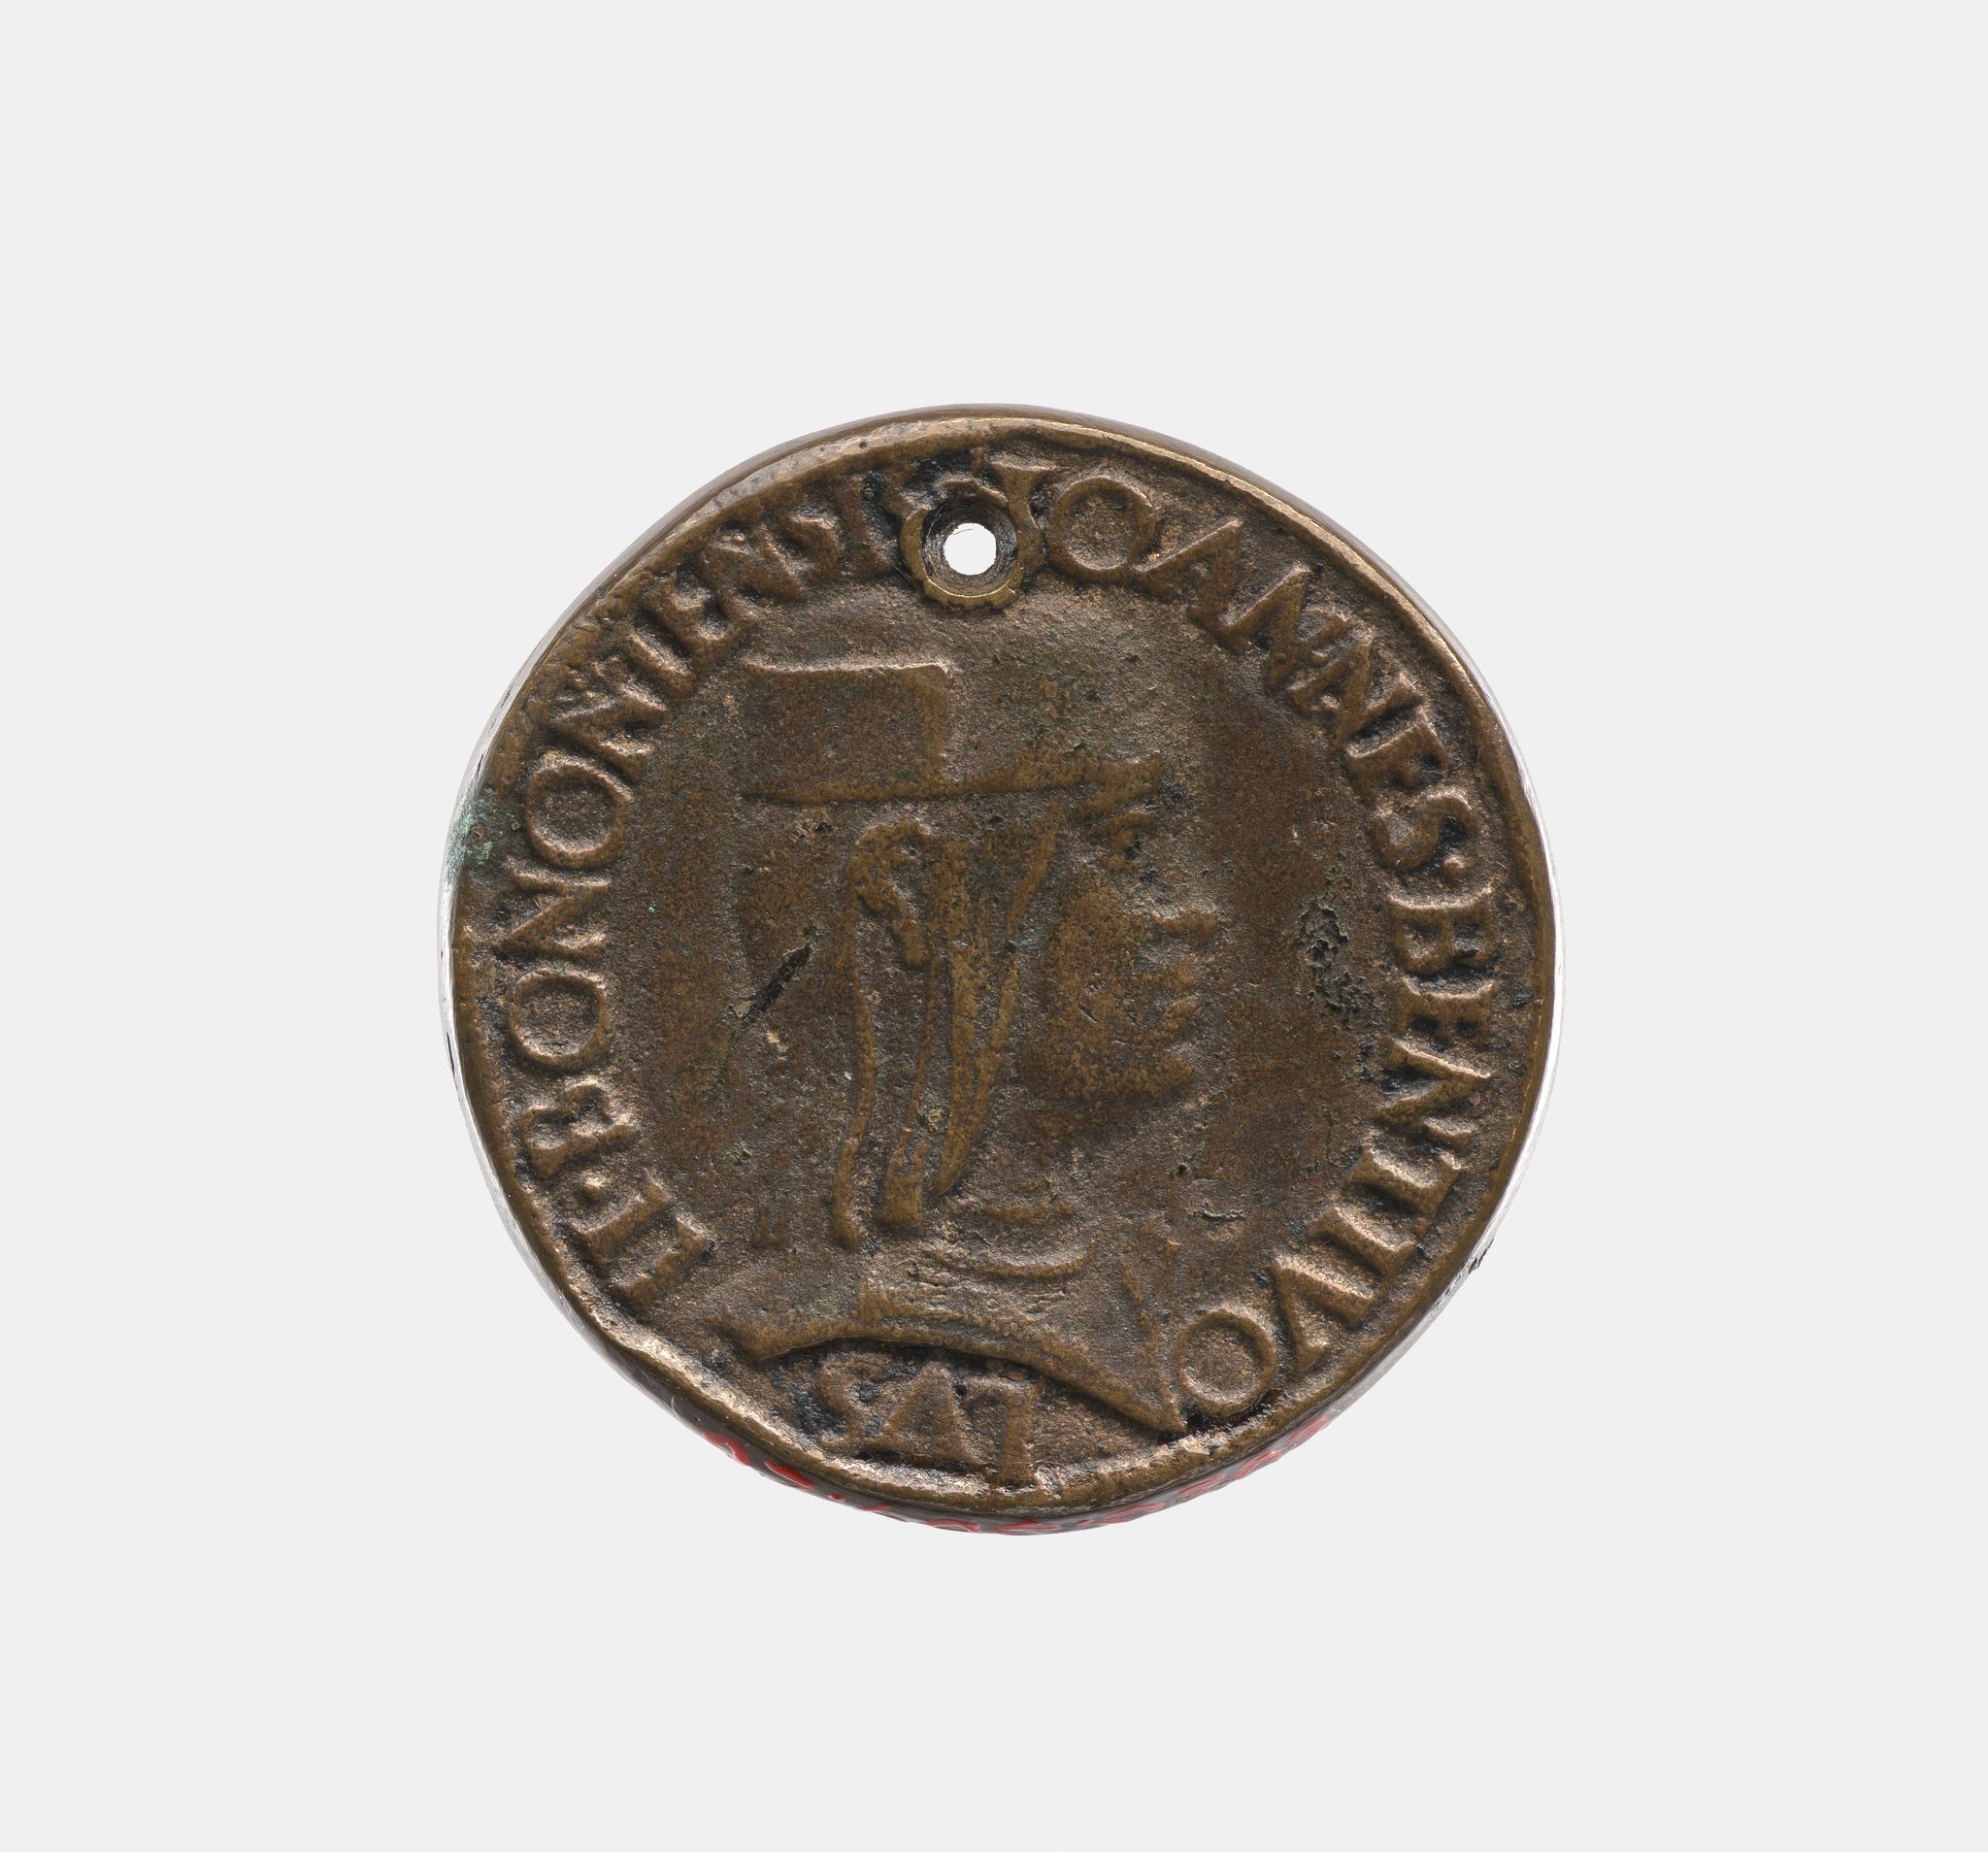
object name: medal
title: Giovanni II Bentivoglio 1443–1508, Lord of Bologna 1463–1506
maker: francesco francia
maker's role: artist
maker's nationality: italian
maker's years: 1447-1517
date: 1494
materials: bronze